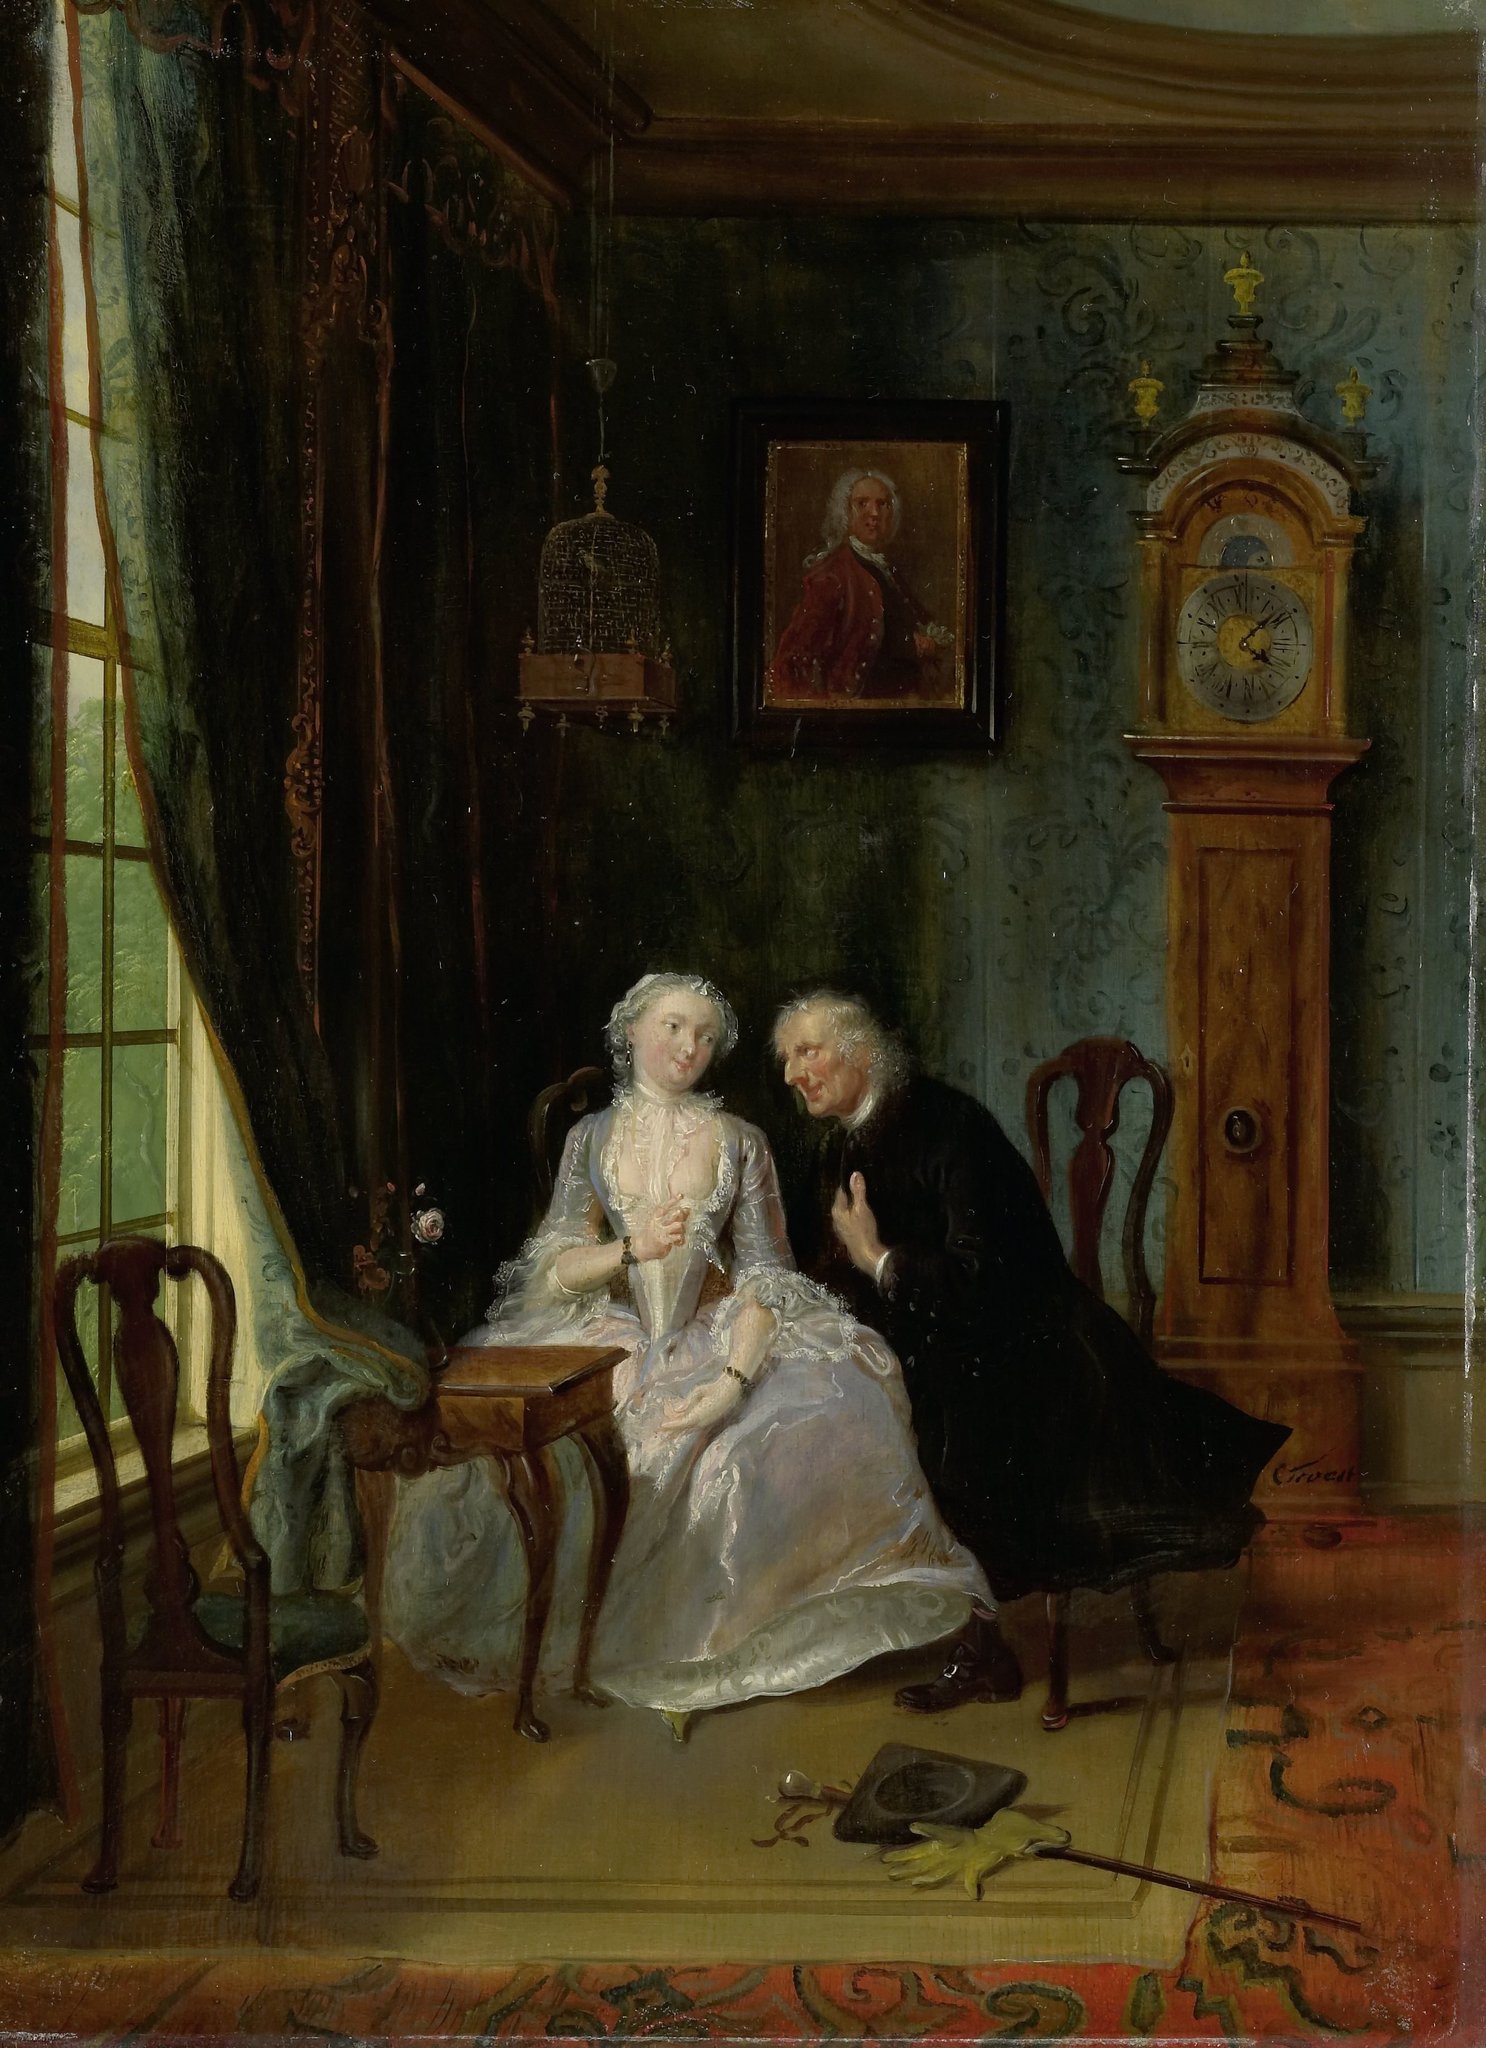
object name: painting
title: "Unseemly Love, perhaps a scene of the Widower Joost with Lucia, 2nd scene from the play ""De wanhebbelijke liefde"" by CJ van der Lijn "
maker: cornelis troost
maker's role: draughtsman, painter, print maker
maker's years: 1696-1750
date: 1720-1750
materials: oil, panel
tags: married couple of unequal age, clock, courting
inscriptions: signature: ‘C. Troost’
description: 'De wanhebbelijke liefde', misschien de scène van de weduwnaar Joost bij Lucia, tweede toneel uit het gelijknamige toneelstuk van C.J. van der Lijn. In een interieur maakt een oudere man een jonge vrouw het hof. Op de achtergrond een vogelkooi, een schilderij met een mansportret en een staande horloge.